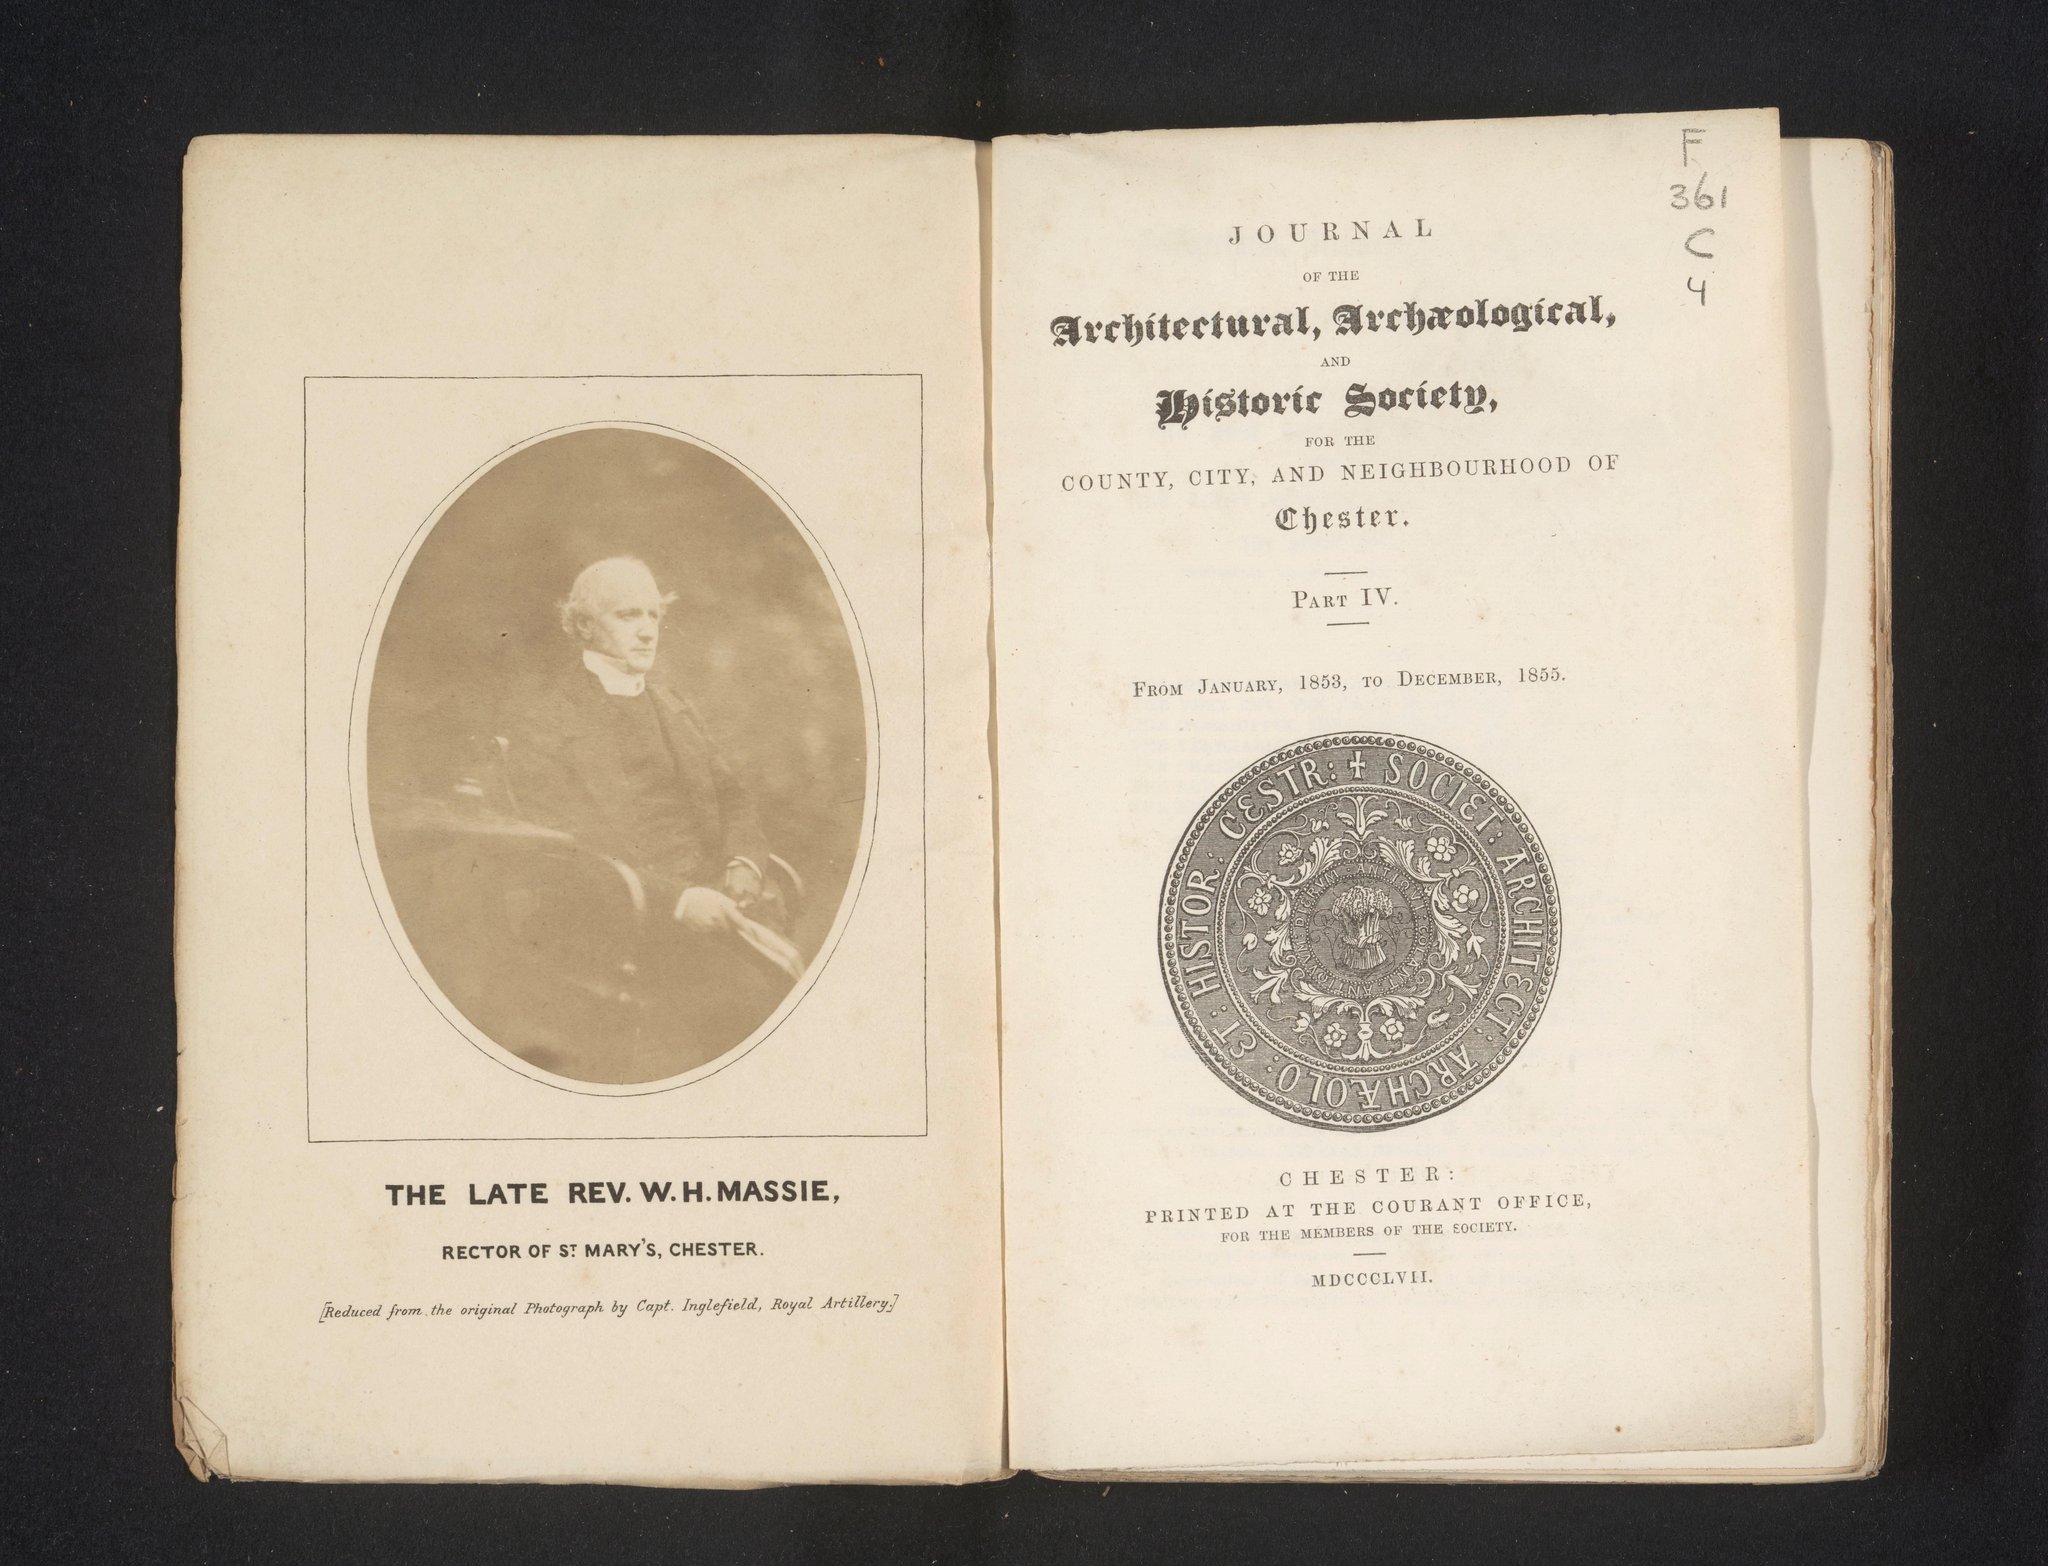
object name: magazine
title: Journal of the Architectural, Archaeological, and Historic Society for the County, City, and Neighbourhood of Chester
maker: Anonymous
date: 1857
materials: cardboard, linen, paper, photographic support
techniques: printing, salted paper print, engraving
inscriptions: annotation: ‘124 leden’, bookplate: ‘EX/ SFJ/ LIBRIS’, number: ‘65’, date: ‘DEC 1982’, annotation: ‘Sample Hillyard.’, annotation: ‘2/40 see p. 383 1857’